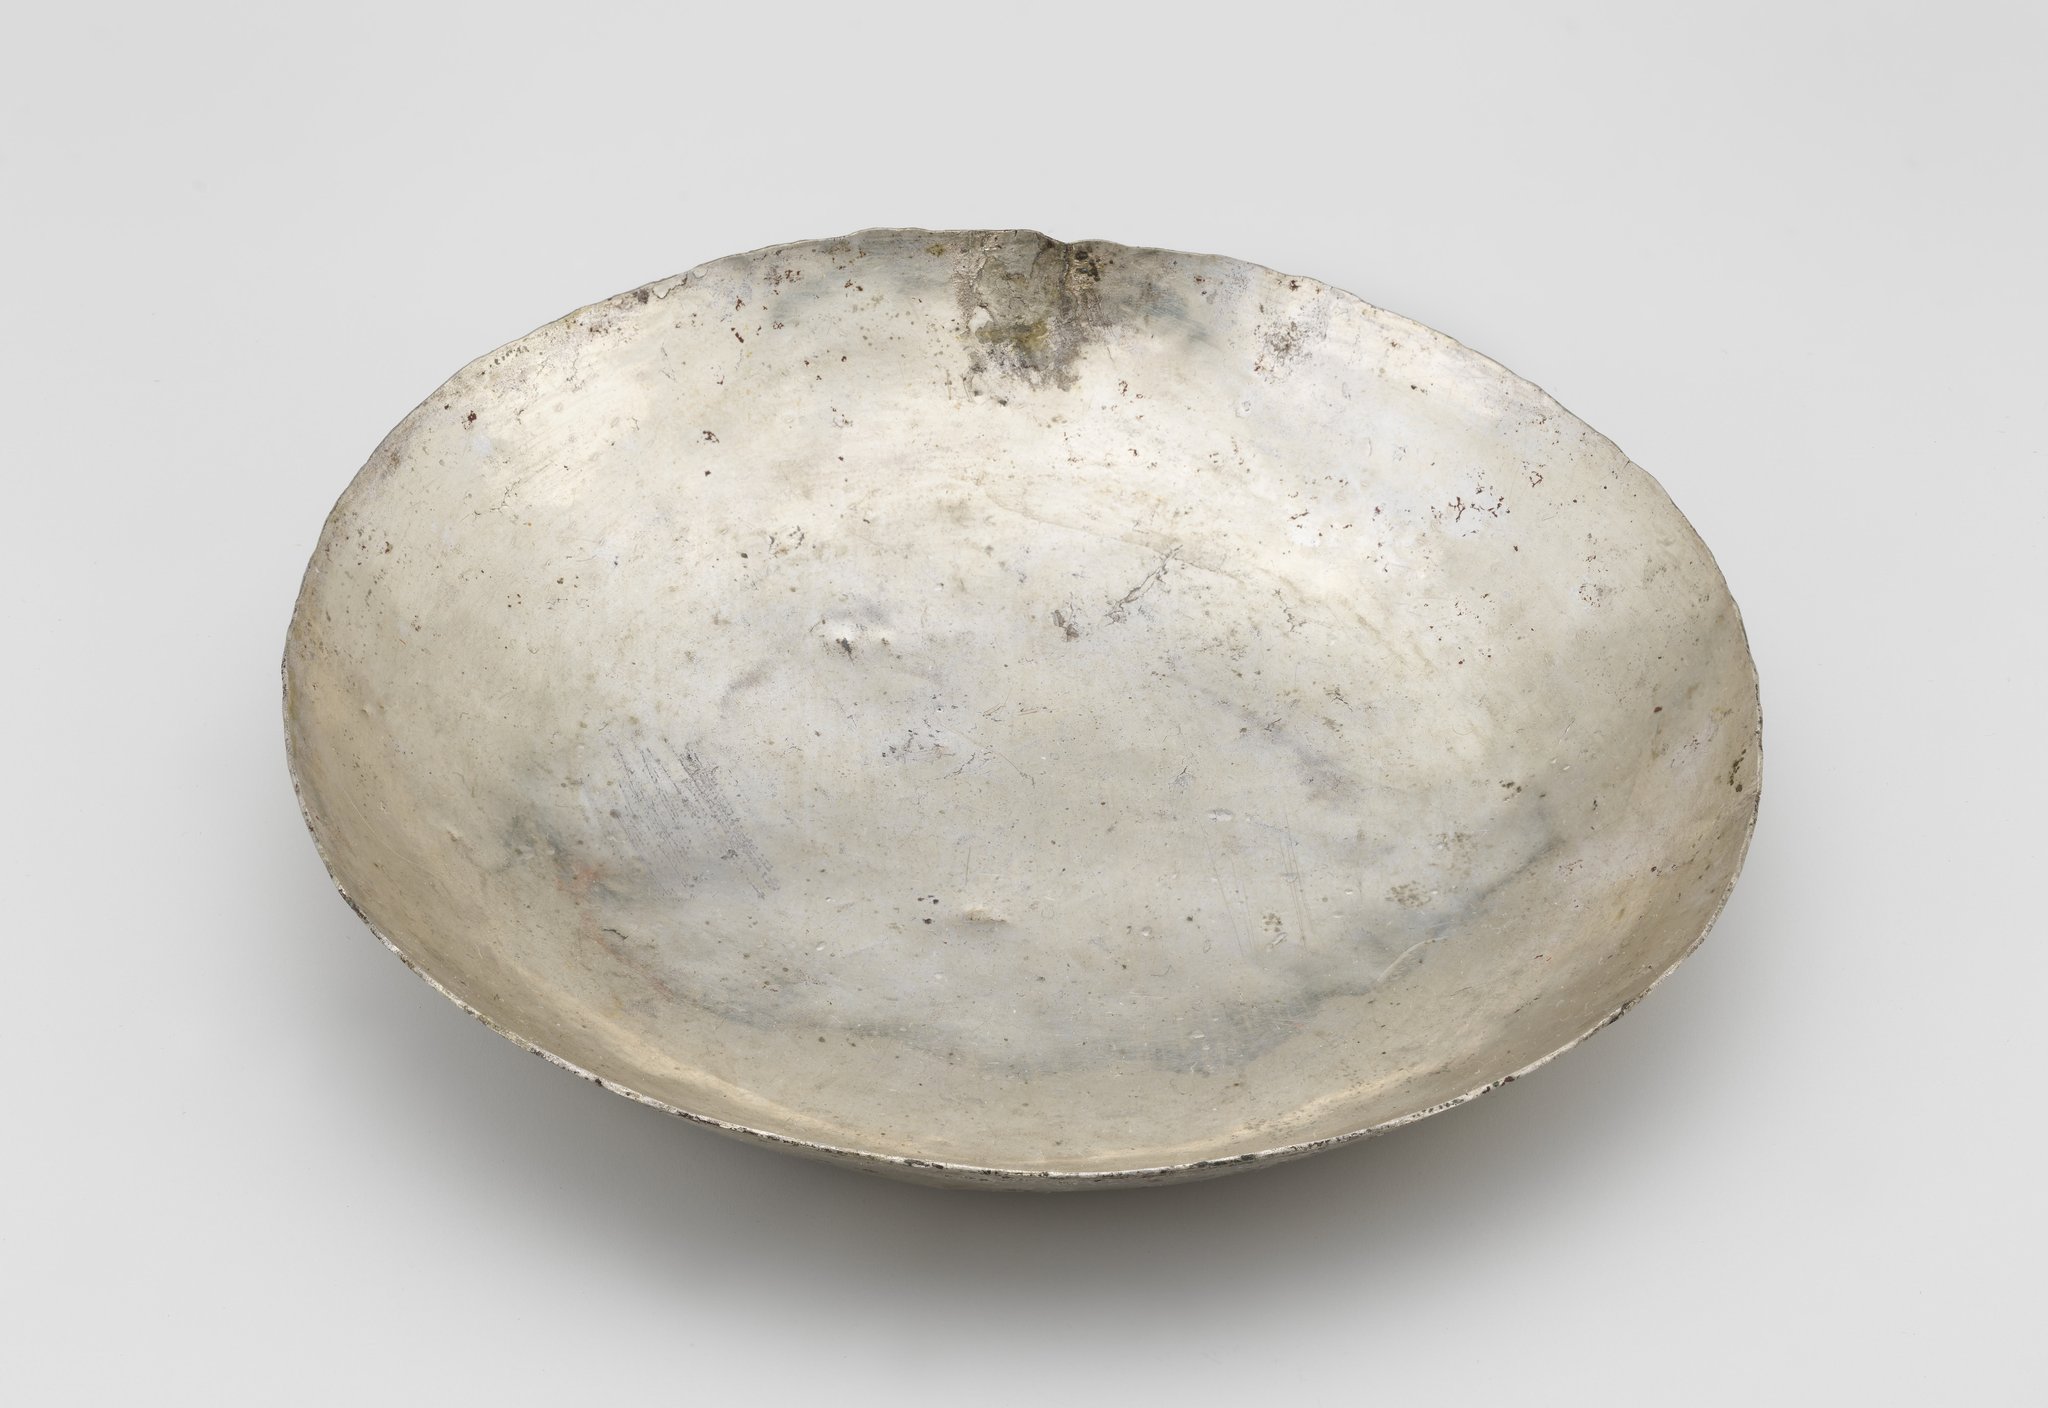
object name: plate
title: Miniature plate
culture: chancay or chimú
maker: chimú or chancay artist(s)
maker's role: artist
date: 1300-1470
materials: silver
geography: peru